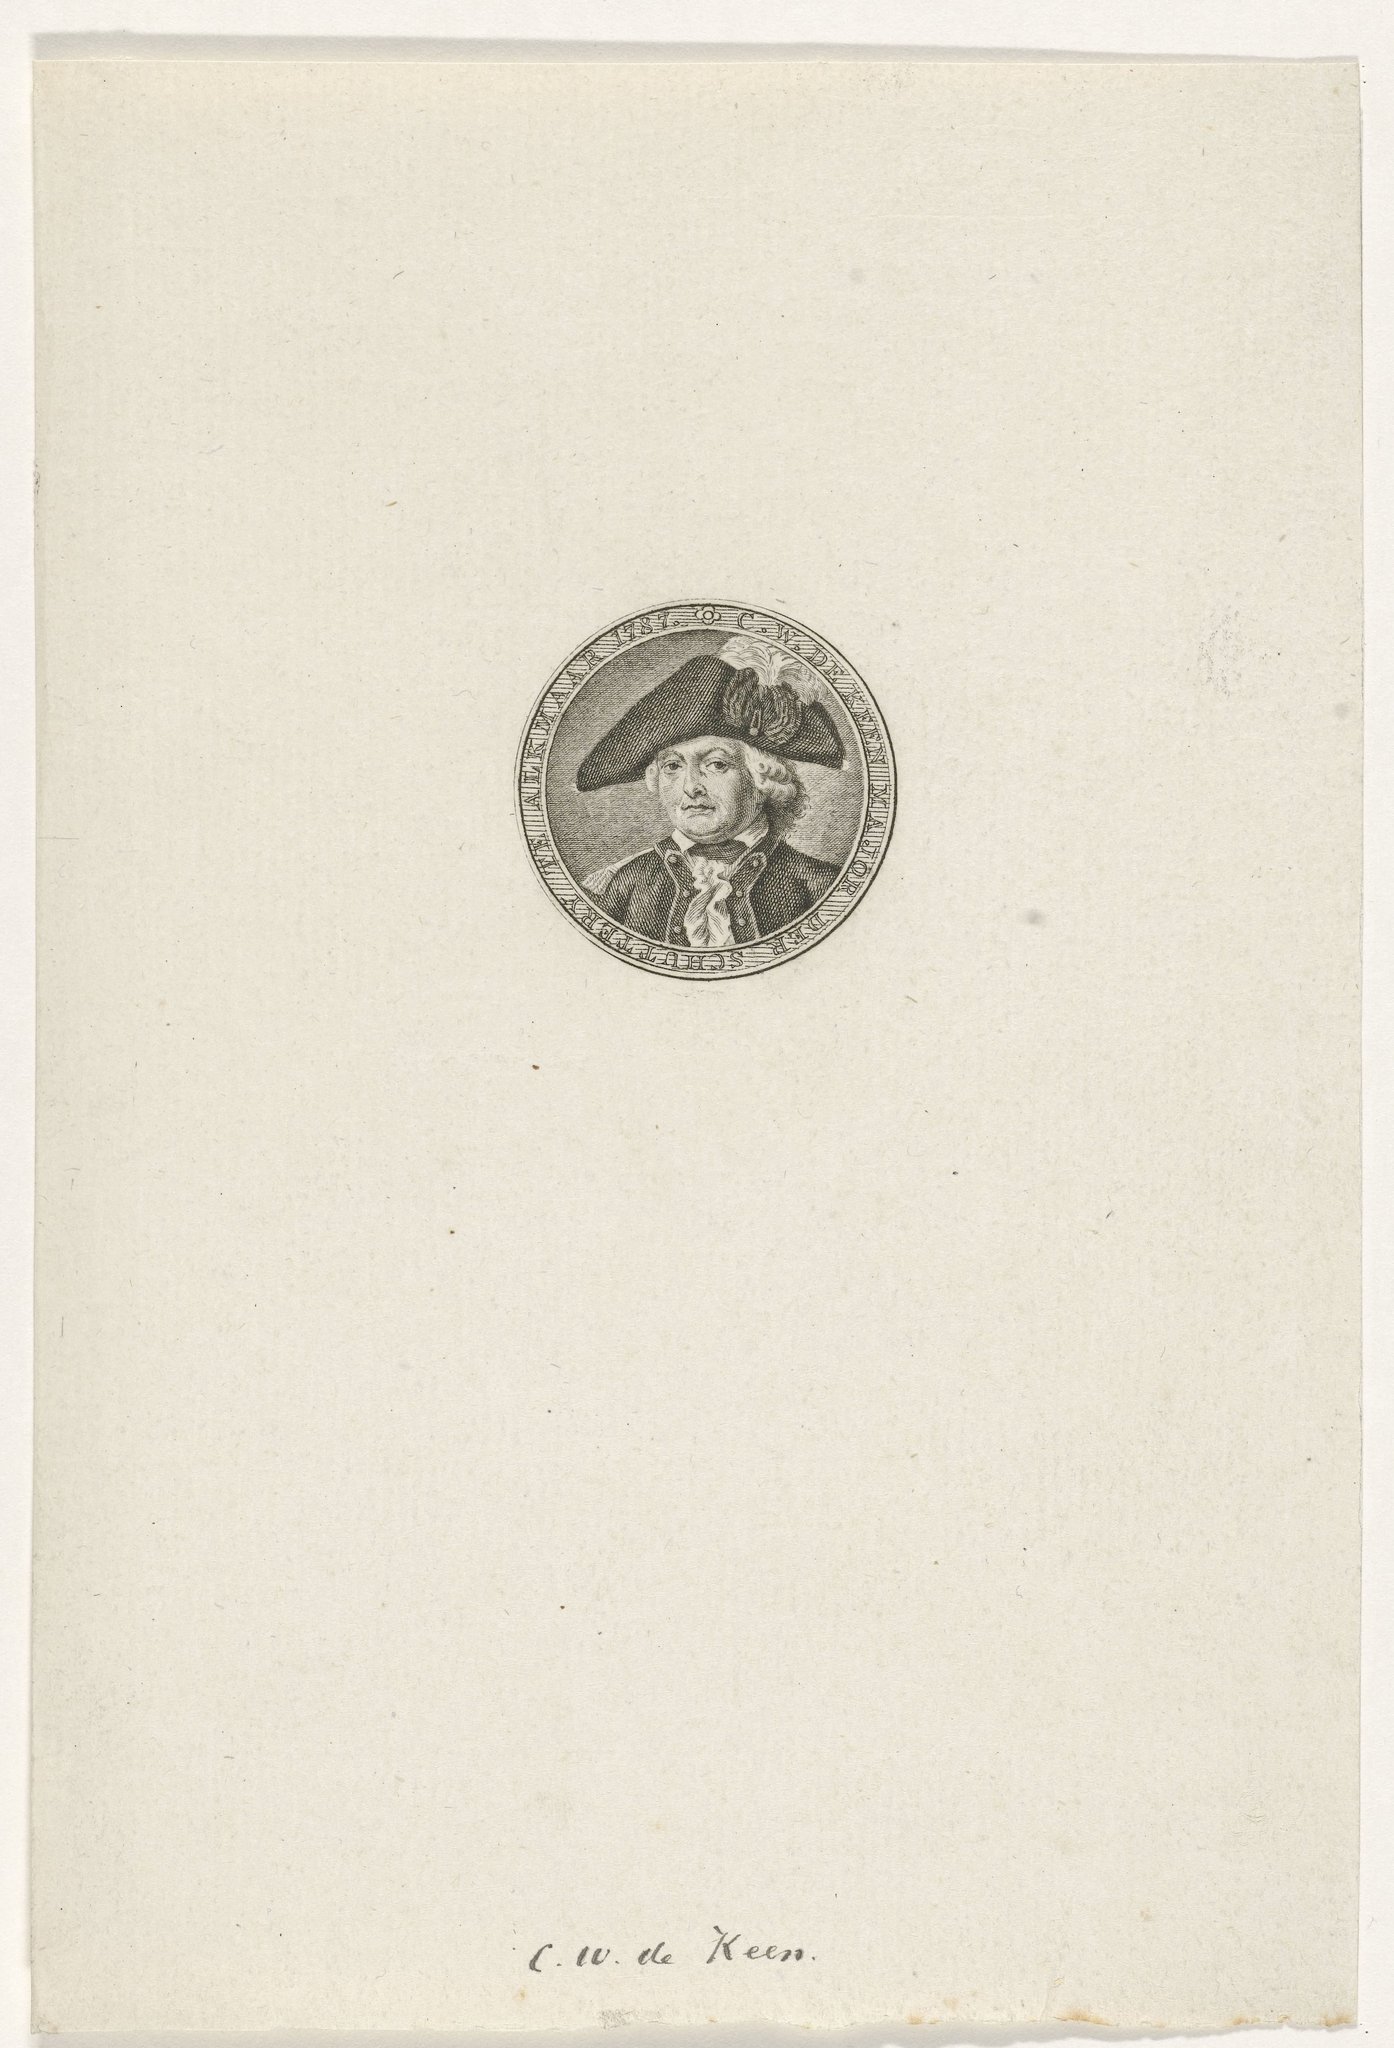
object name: print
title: Portret van C.W. de Keen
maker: abraham jacobsz. hulk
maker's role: print maker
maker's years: 1751-1817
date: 1787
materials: paper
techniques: engraving, etching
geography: paris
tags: c.w. de keen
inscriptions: collector's mark: Lugt 2228, inscription: ‘C.W. de Keen’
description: Buste van C.W. de Keen in een medaillon met randschrift in het Nederlands.